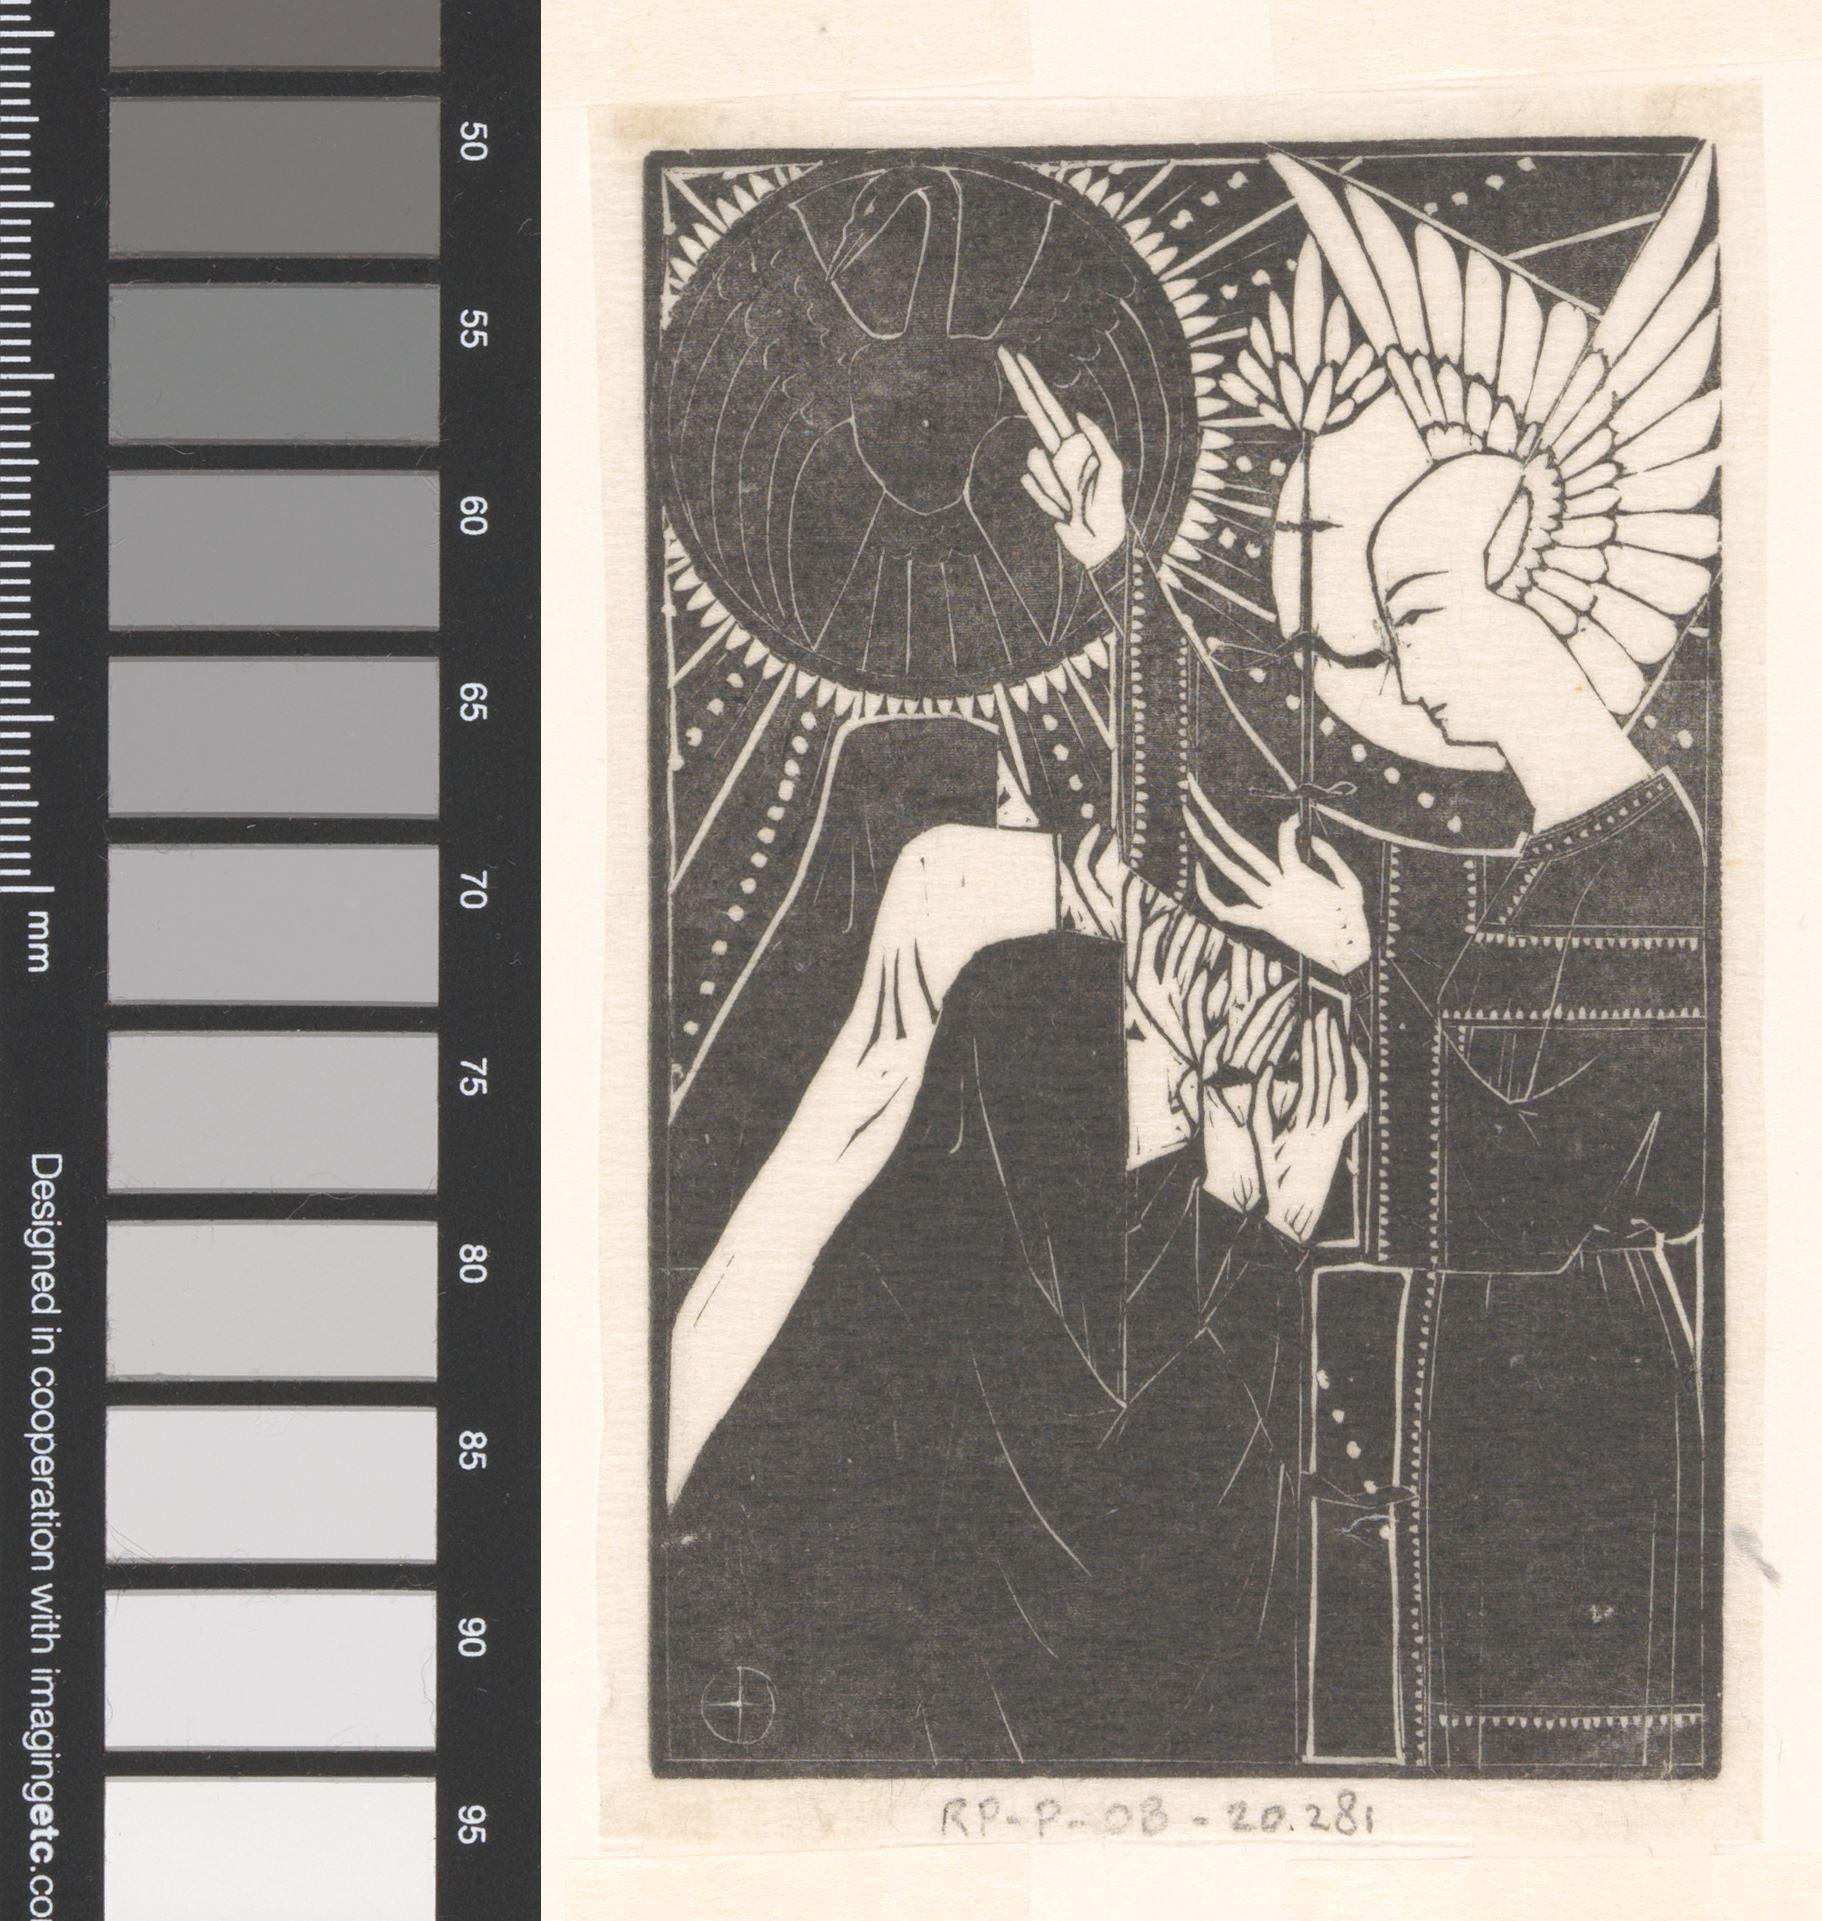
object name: illustration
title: Drie knielende figuren voor gevleugelde man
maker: mathieu lauweriks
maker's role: designer, draughtsman, print maker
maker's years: 1864-1932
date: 1895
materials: paper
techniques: woodcut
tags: kneeling figure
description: Rechts staat een man met vleugels in plaats van oren. Hij wendt zich tot de drie figuren die voor hem knielen. In zijn linkerhand houdt hij een bloem; met rechts wijst hij naar de zon waarin een vogel met gespreide vleugels te zien is.